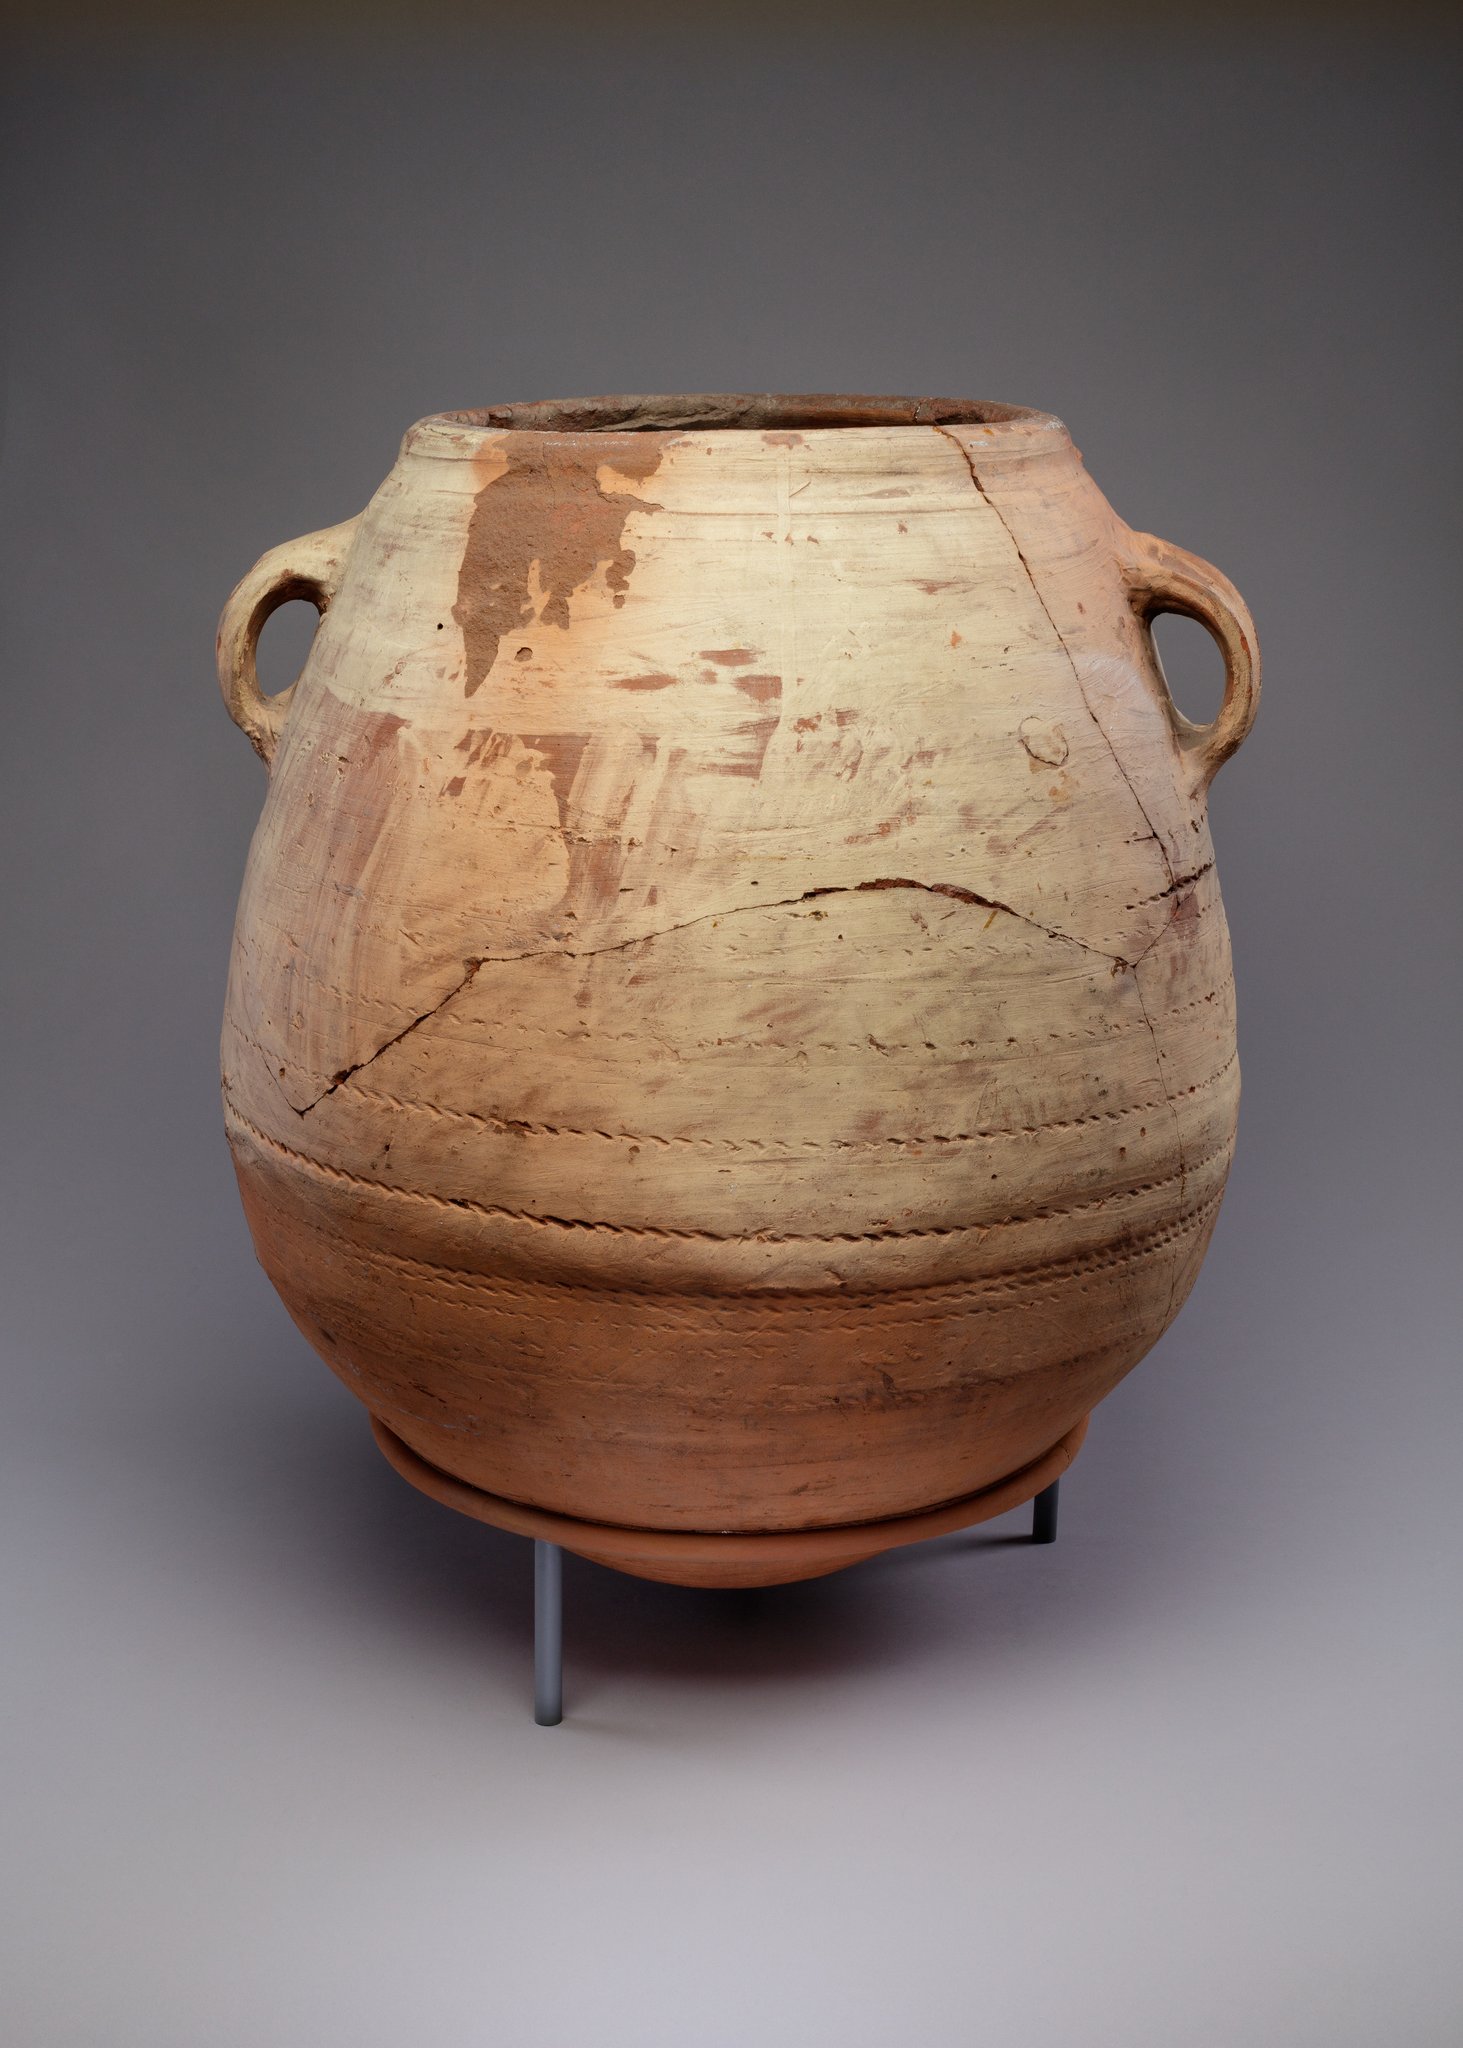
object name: jar, round bottomed, red ware, two handled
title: Two-handled globular jar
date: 1886-1070 BCE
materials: pottery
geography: egypt